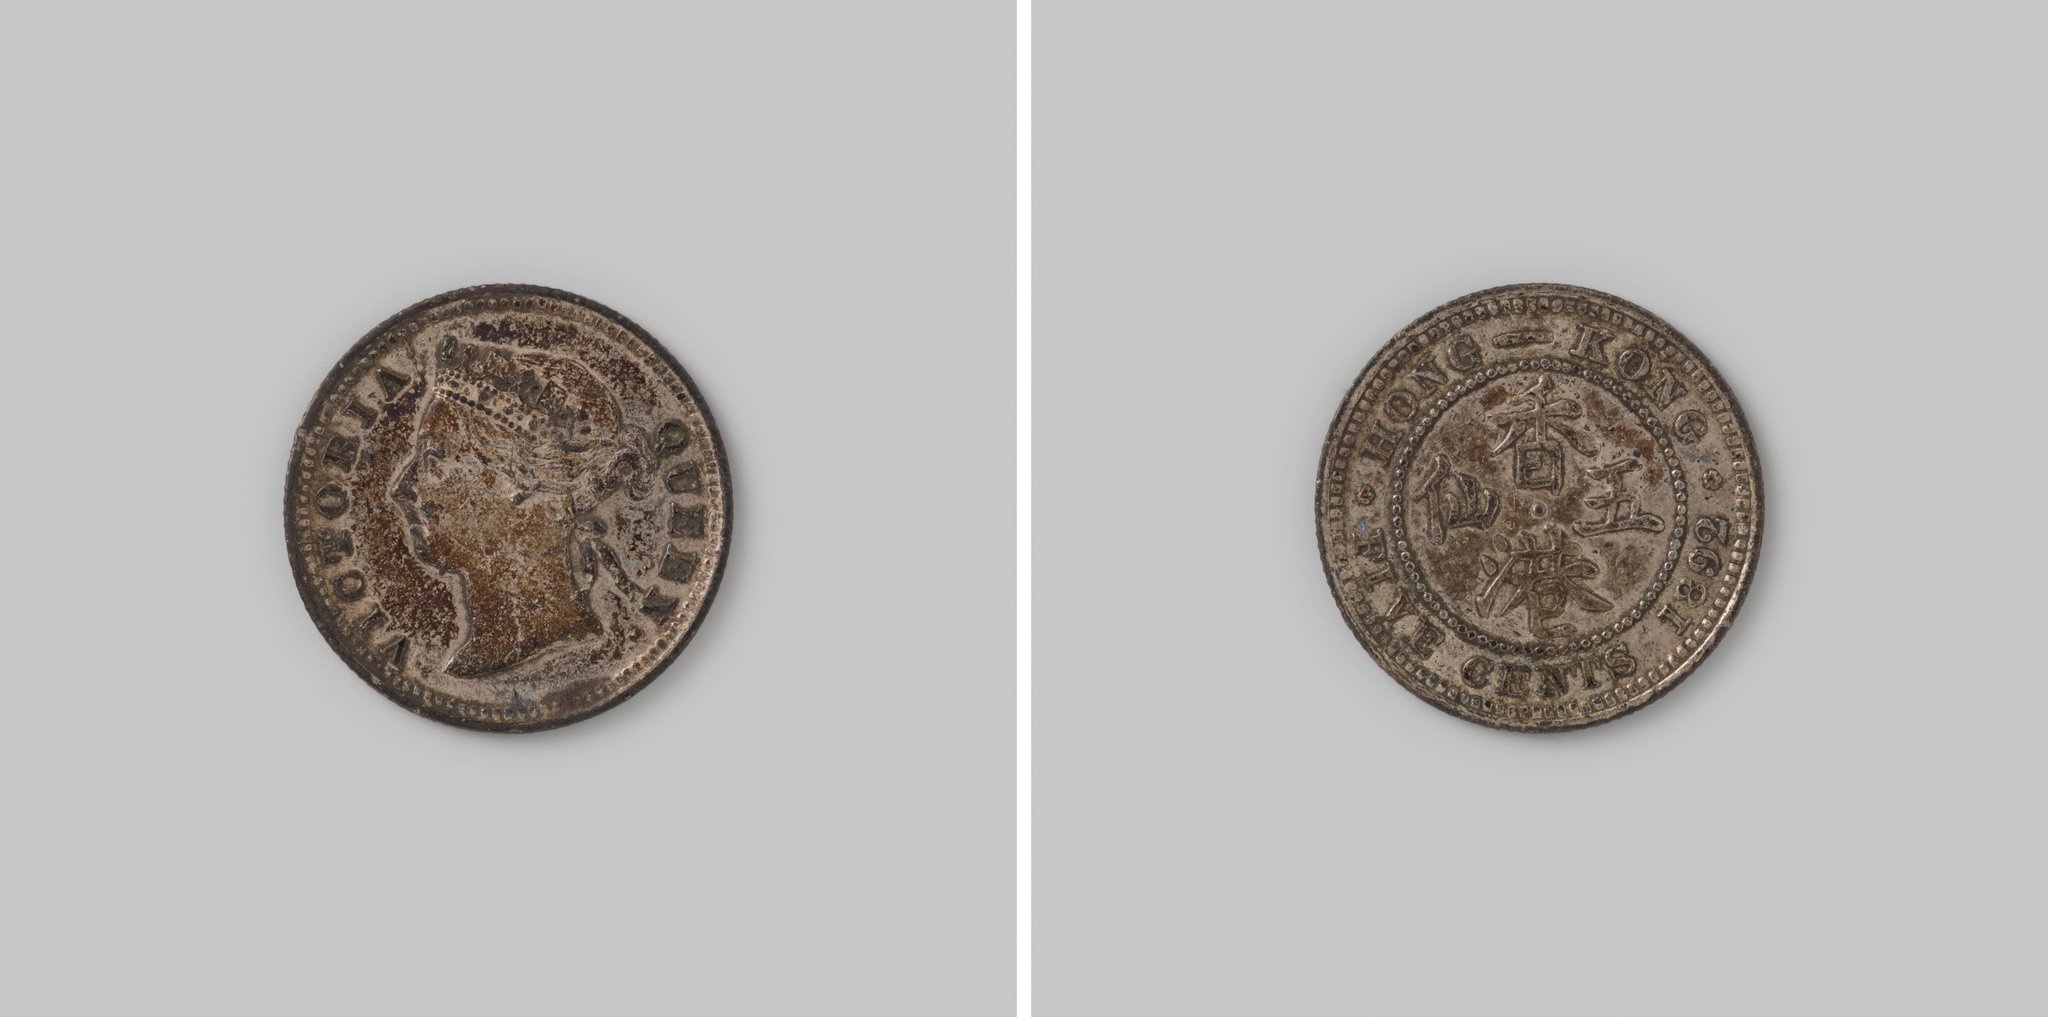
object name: coin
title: Hongkong, koningin Victoria, 5 cents, 1892 H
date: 1892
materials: silver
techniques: striking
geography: birmingham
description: Zilveren munt. Voorzijde: hoofd van de koningin met diadeem naar links. Daaronde letter H [=Heaton-mint te Birmingham]. Keerzijde: in het omschrift waarde-aanduiding: 5 cents met rechts daarvan jaartal. Kartelrand.